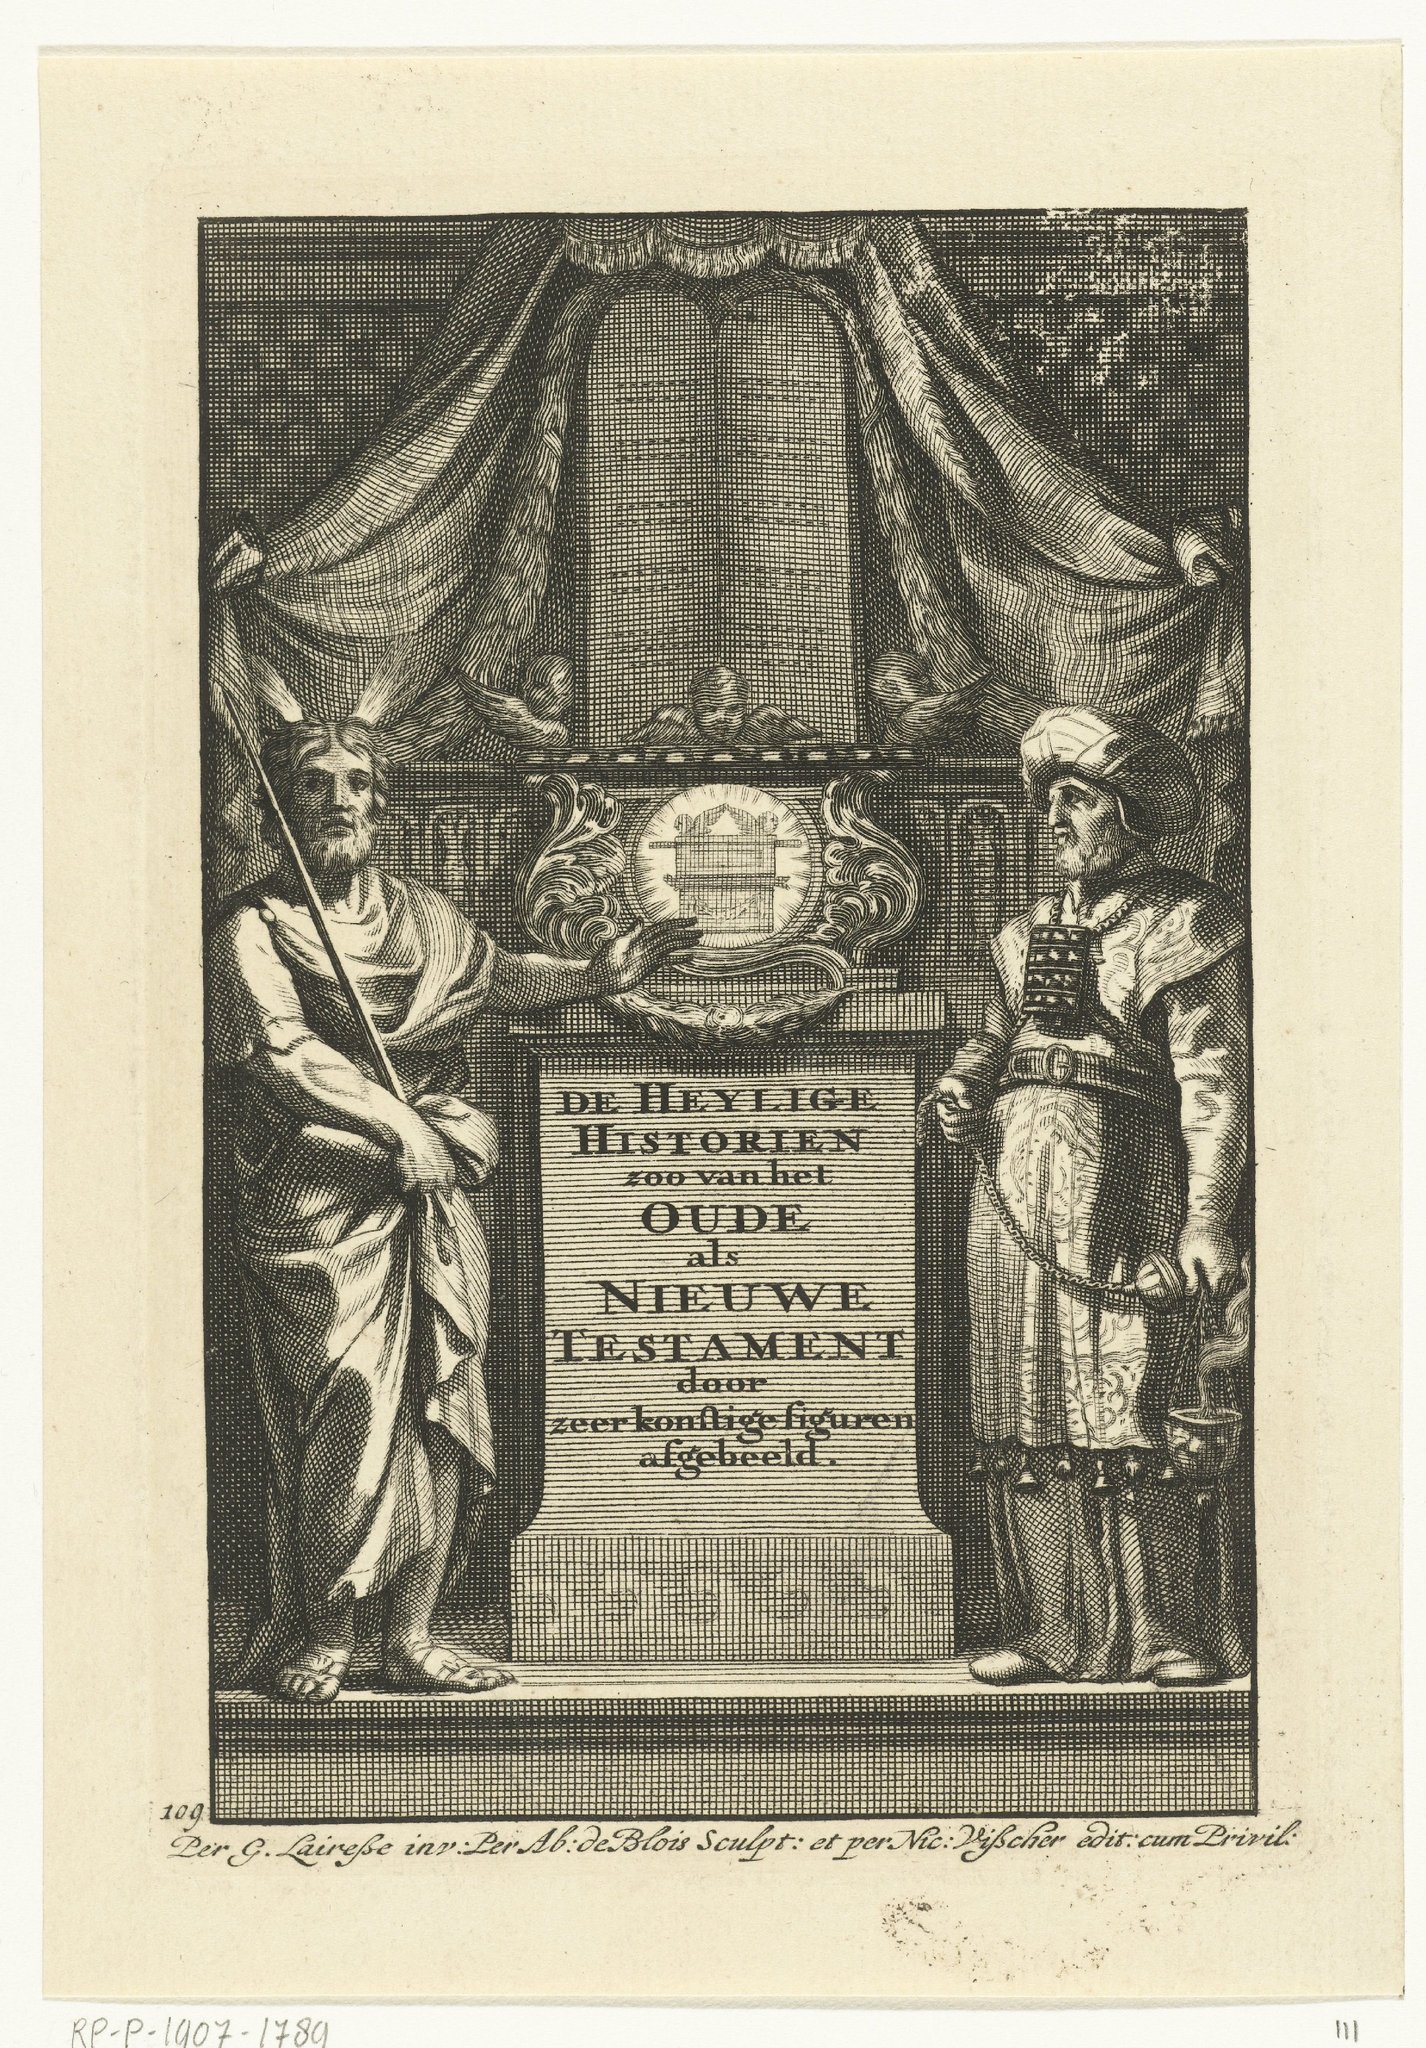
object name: print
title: Allegorie op het Oude en Nieuwe Testament met Mozes en Aäron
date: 1651-1679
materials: paper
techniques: engraving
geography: amsterdam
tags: ark of the covenant ~ jewish religion, aaron (not in biblical context); possible attributes: attributes of aaron: censer, dressed as high priest or bishop, ointment jar, rod or flowering wand, moses (not in biblical context); possible attributes: rays of light or horns on his head, rod, tables of the law, the ten commandments represented together on stone tablets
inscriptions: collector's mark: Lugt 2228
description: Allegorie op het Oude en Nieuwe Testament met verheerlijking van de Tafelen der Wet en de Ark des Verbonds op een voetstuk. Mozes en Aäron als hogepriester staan aan weerszijden.